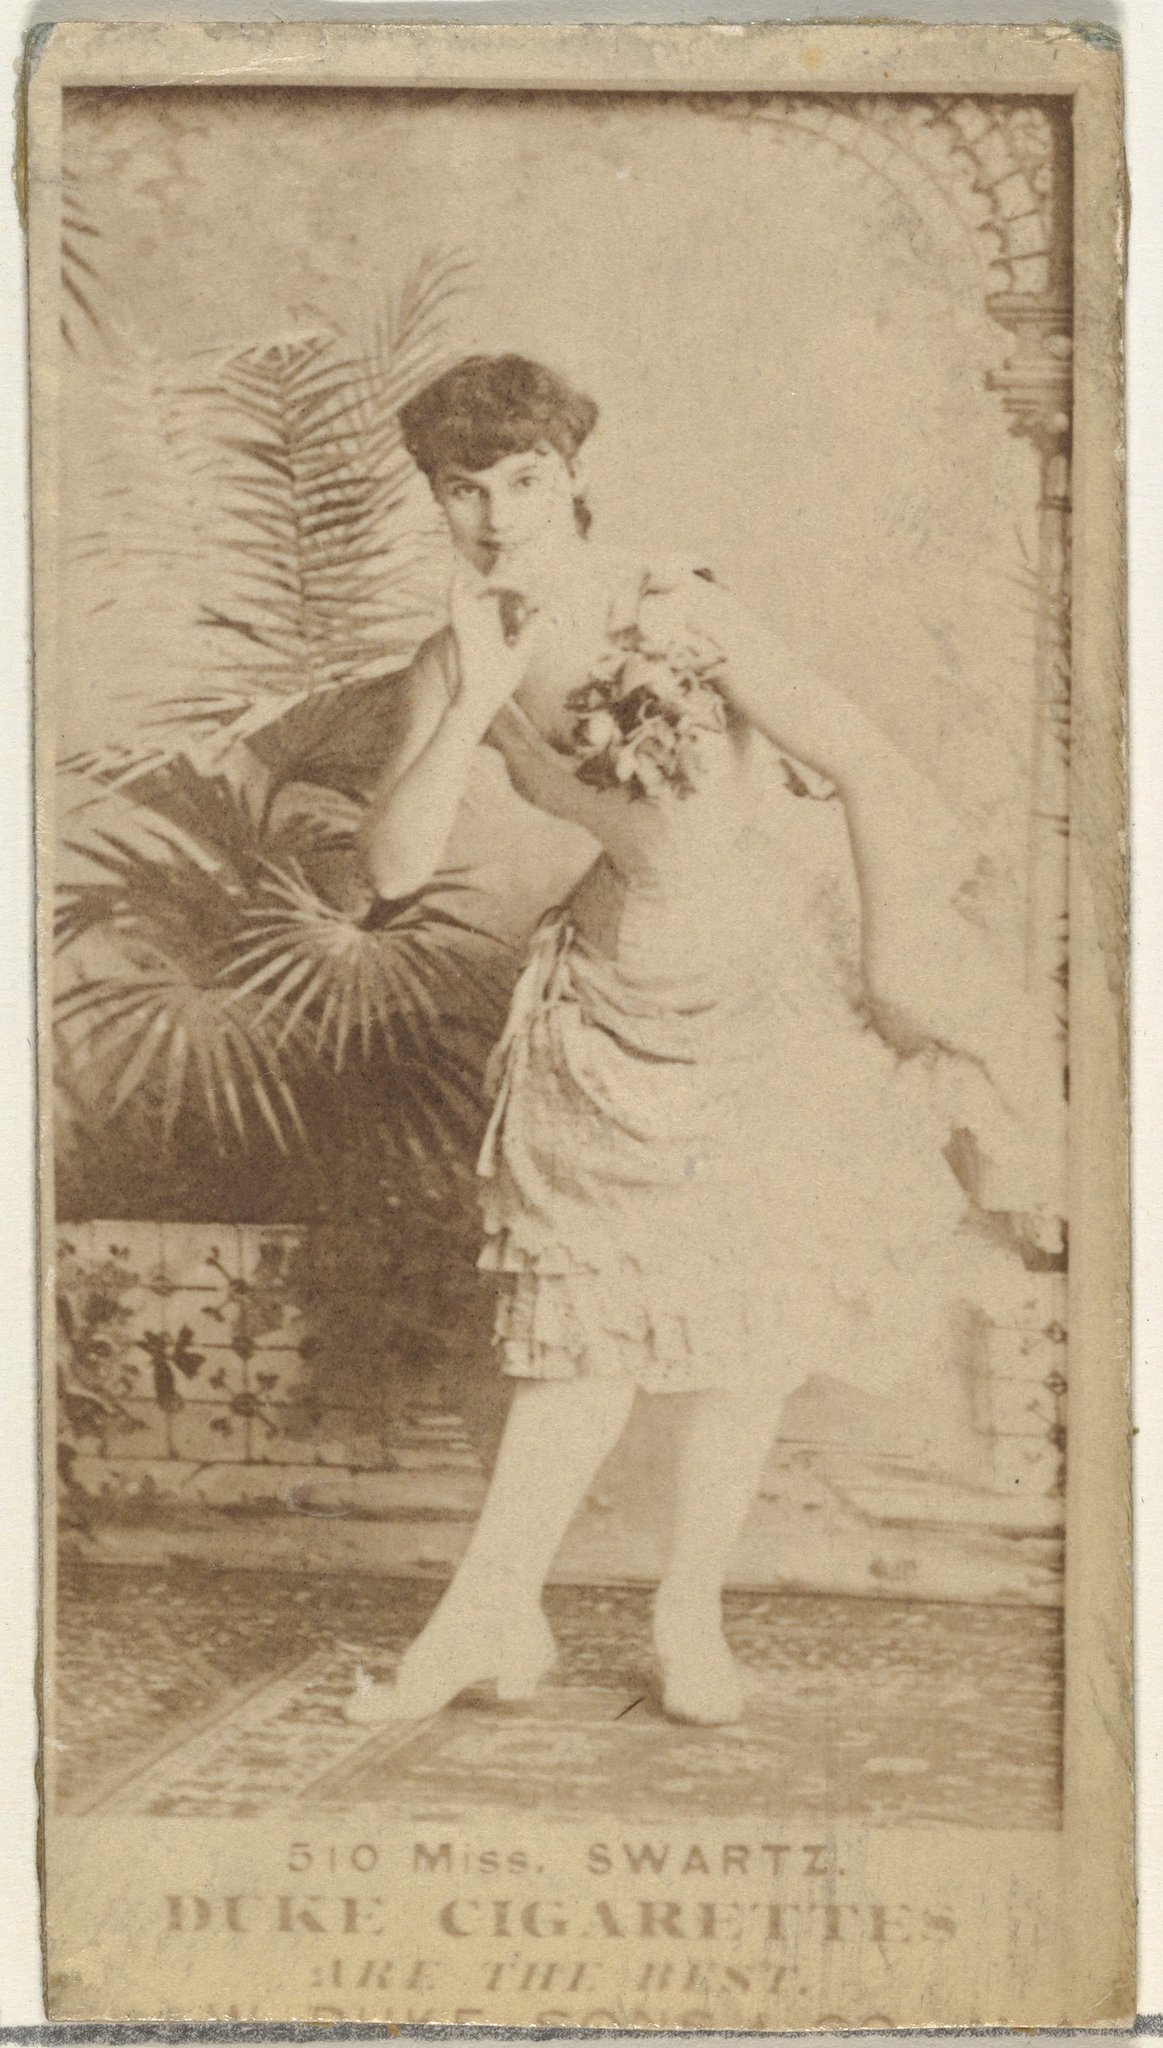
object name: photograph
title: Card Number 510, Miss Schwartz, from the Actors and Actresses series (N145-7) issued by Duke Sons & Co. to promote Duke Cigarettes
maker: w. duke, sons & co.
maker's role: publisher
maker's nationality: american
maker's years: 1870-1920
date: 1880-1889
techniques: albumen silver print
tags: portraits,women,actresses